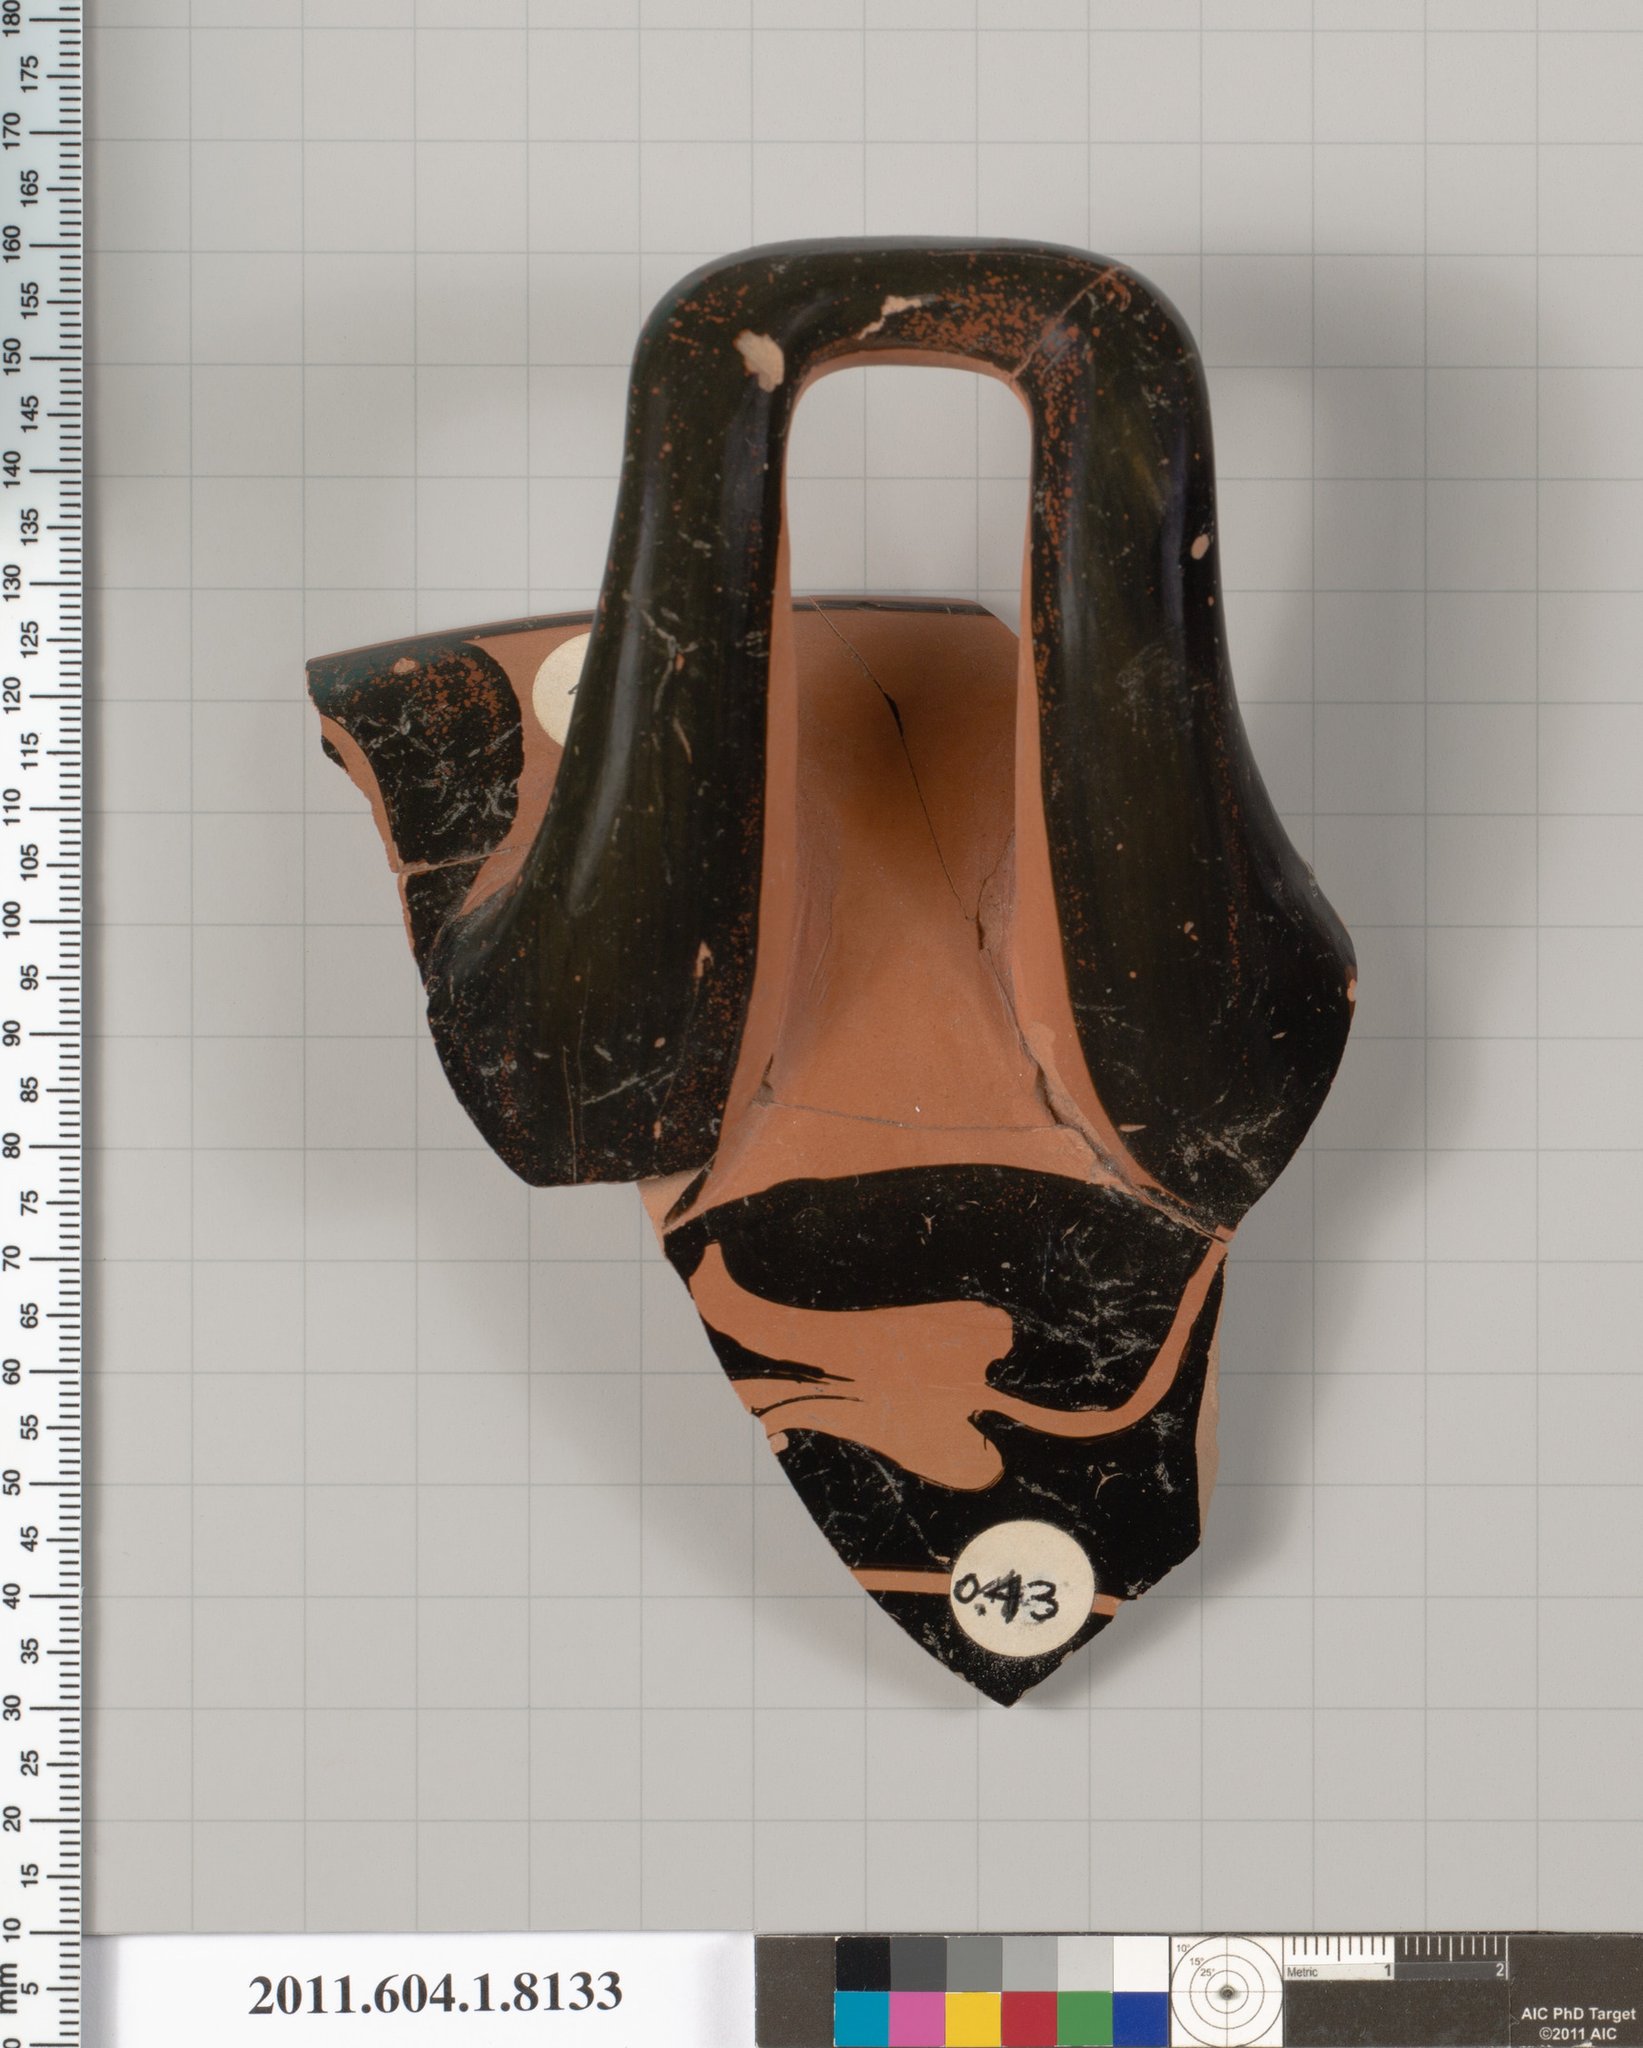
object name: kylix fragment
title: Terracotta fragment of a kylix (drinking cup)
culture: greek, attic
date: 534-468 BCE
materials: terracotta